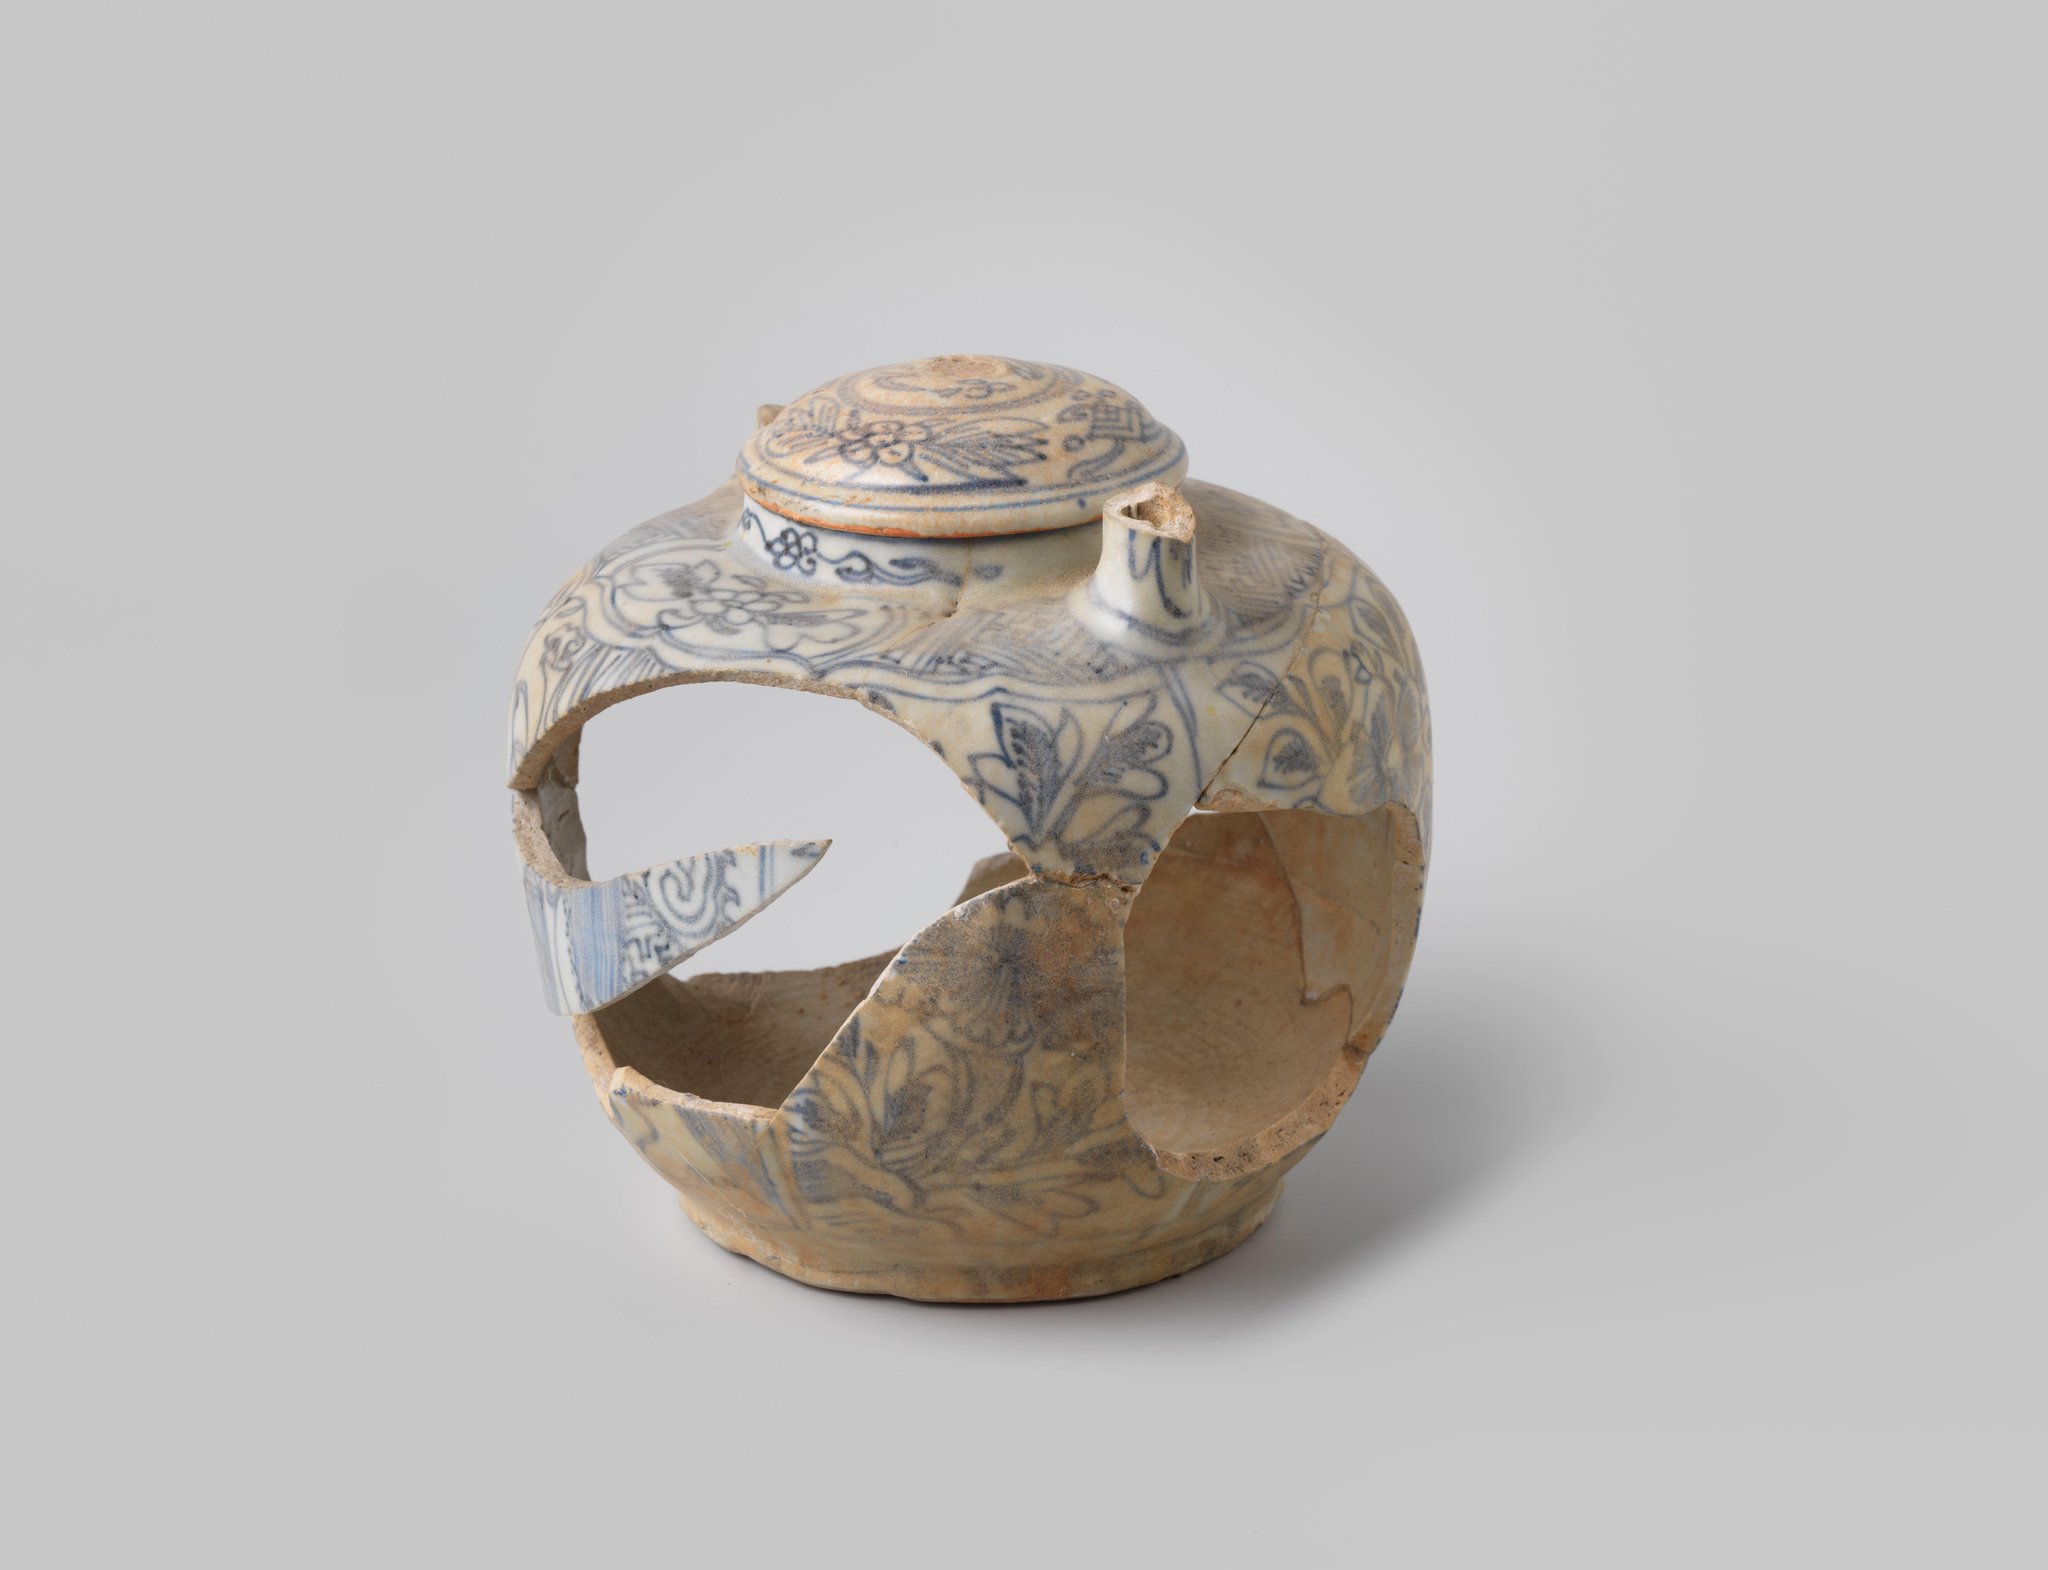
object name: wijnstoop, wijnkaraf, wijnkan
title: Wijnkan met deksel uit V.O.C.-schip de 'Witte Leeuw'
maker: Anonymous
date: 1613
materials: bone china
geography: jingdezhen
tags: verenigde oostindische compagnie, sint-helena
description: A kendi with a rounded side. Decorated with birds and flowers under a band with diaper patterns. The neck decorated with plantain leaves, the spout with peaches and groups of dots in sections.